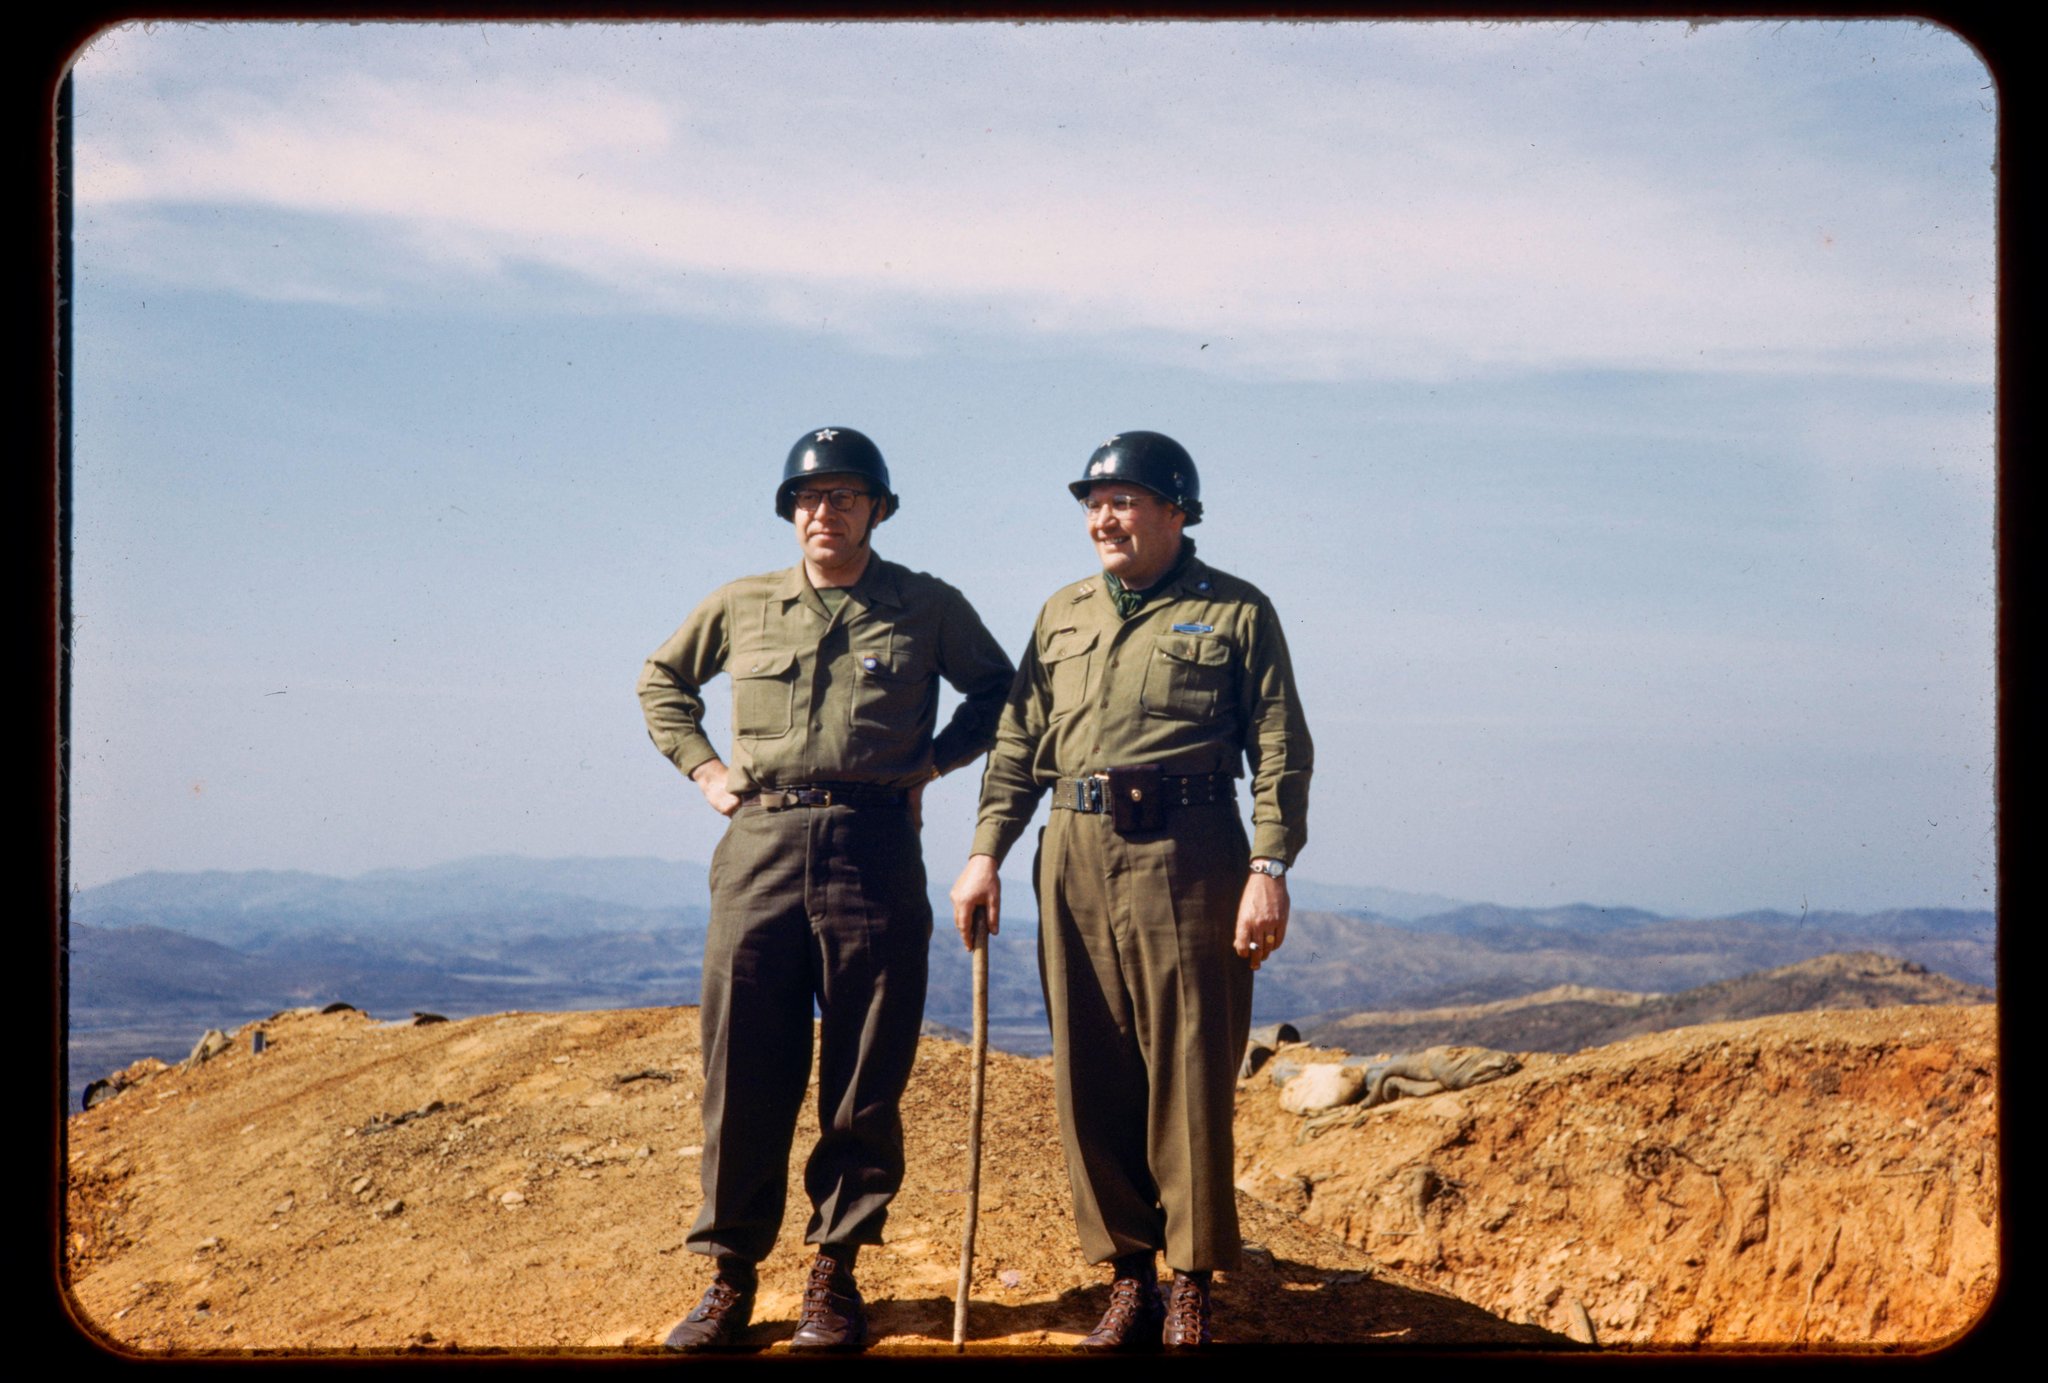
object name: color slide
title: Oorlog in Korea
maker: david ketel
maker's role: diplomaat, sinoloog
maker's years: 1913-2008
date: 1952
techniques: slide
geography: korea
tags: united nations, switzerland, david ketel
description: Aan het front, twee mannen in uniform Nederlandse leger. De linker is David Ketel.